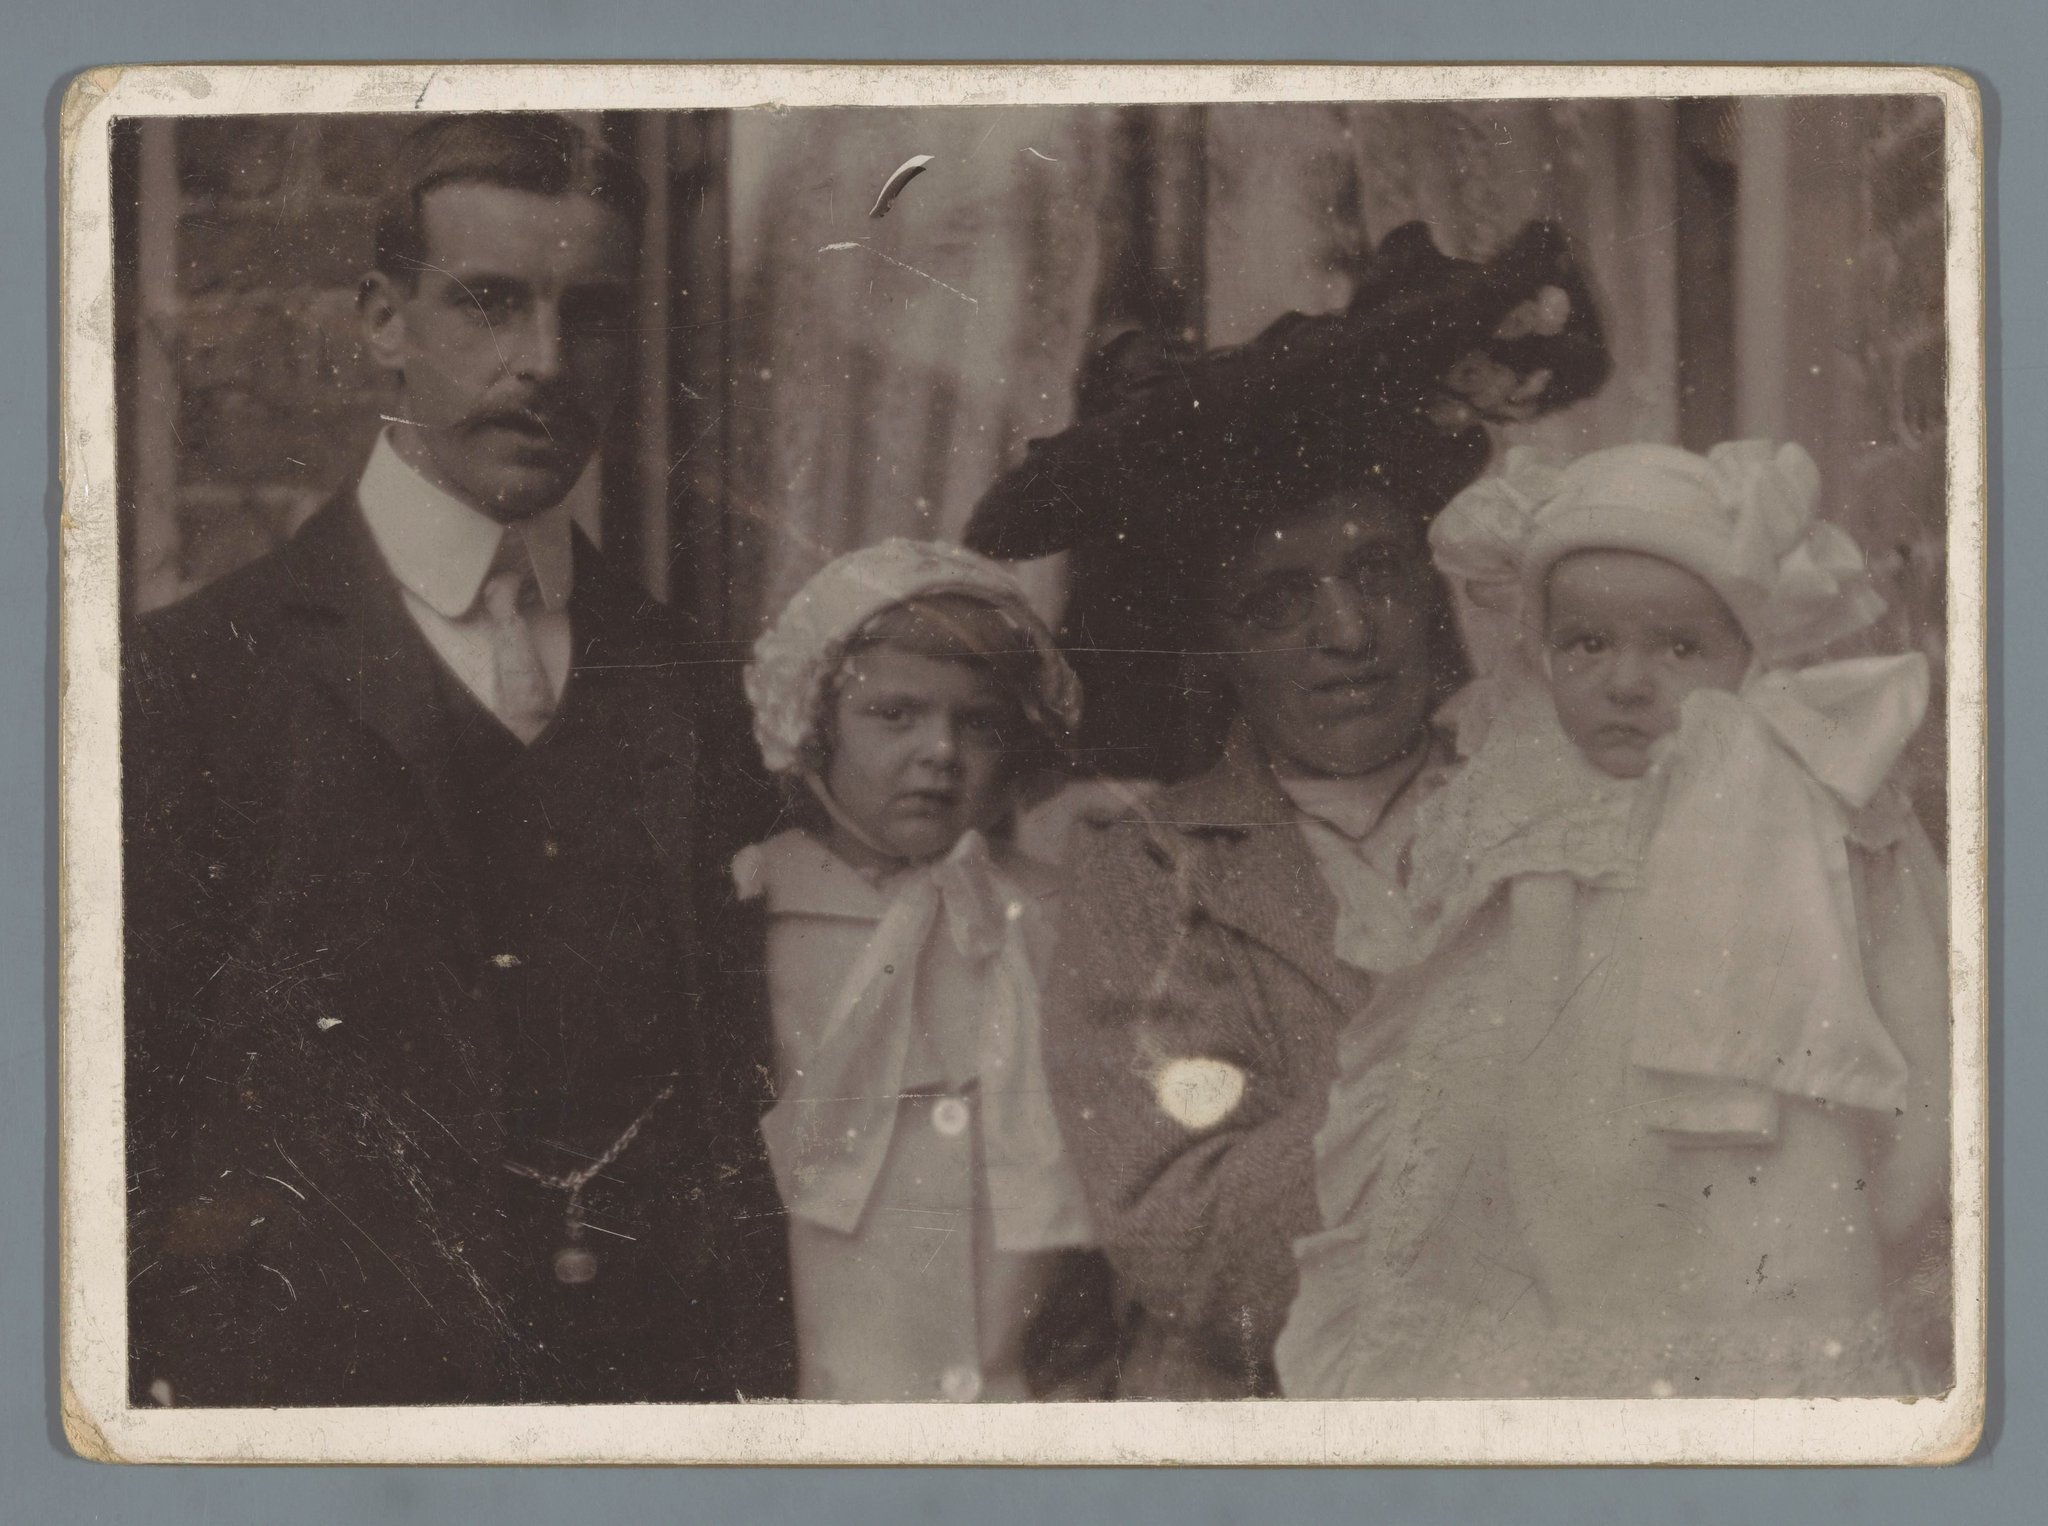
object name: photograph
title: Groepsportret van een gezin met twee kinderen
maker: Anonymous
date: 1900-1920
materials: cardboard, photographic support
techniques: gelatin silver print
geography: netherlands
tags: family group, especially parents with their child(ren)